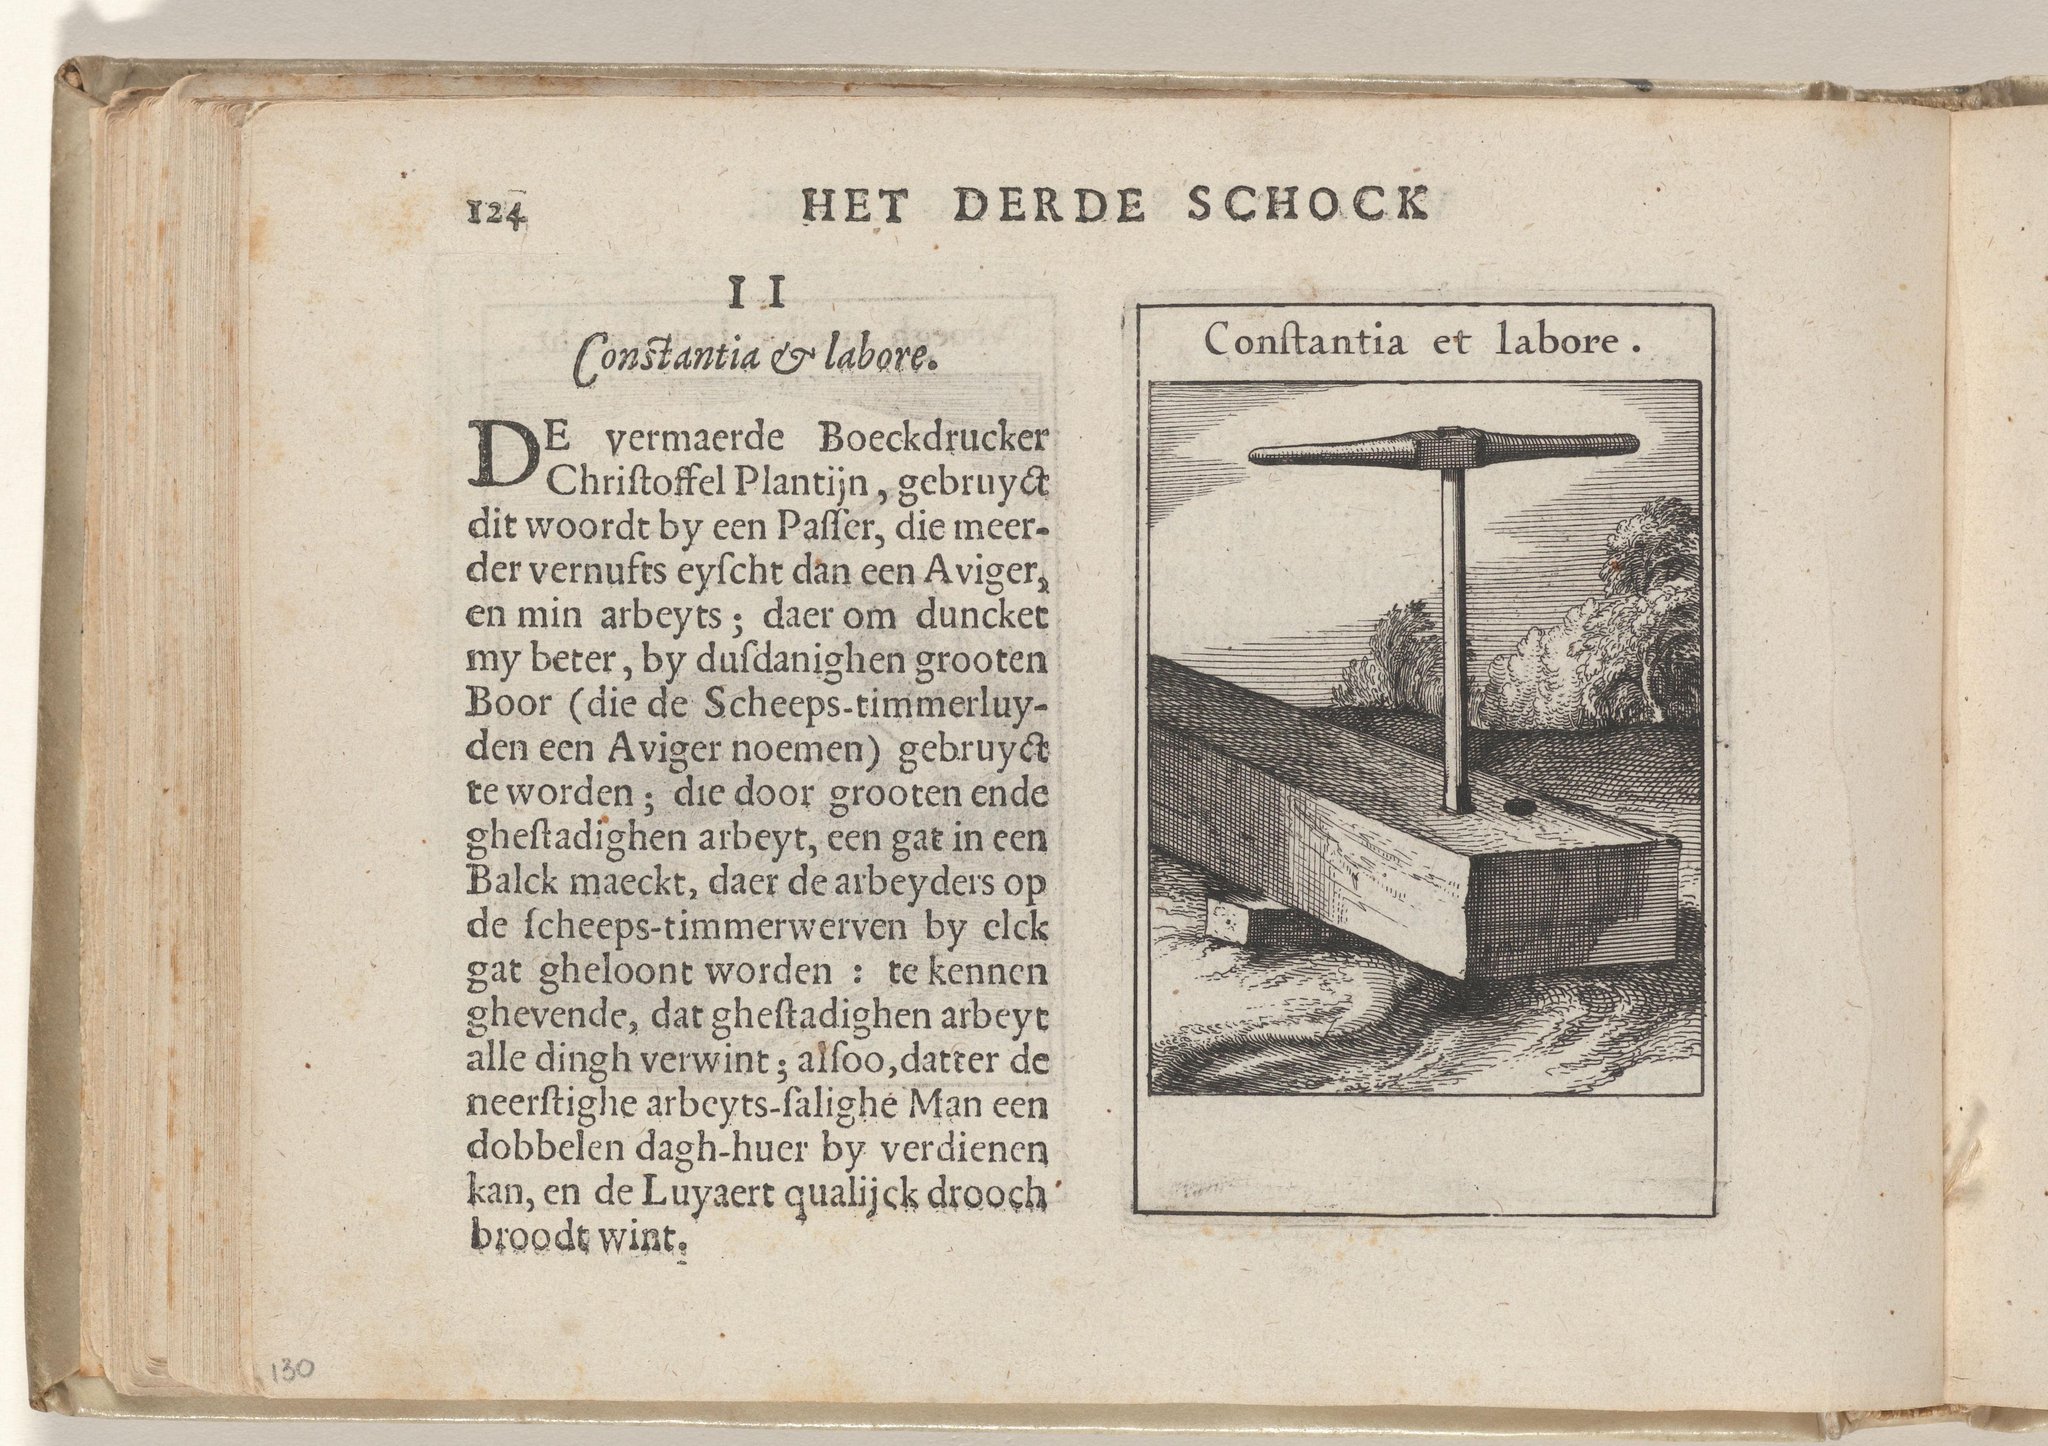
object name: print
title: II Constantia et labore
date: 1614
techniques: engraving, printing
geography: the hague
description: II Constantia et labore. Derde schok. Onderdeel van 'Sinnepoppen', R. Visscher, 1614.